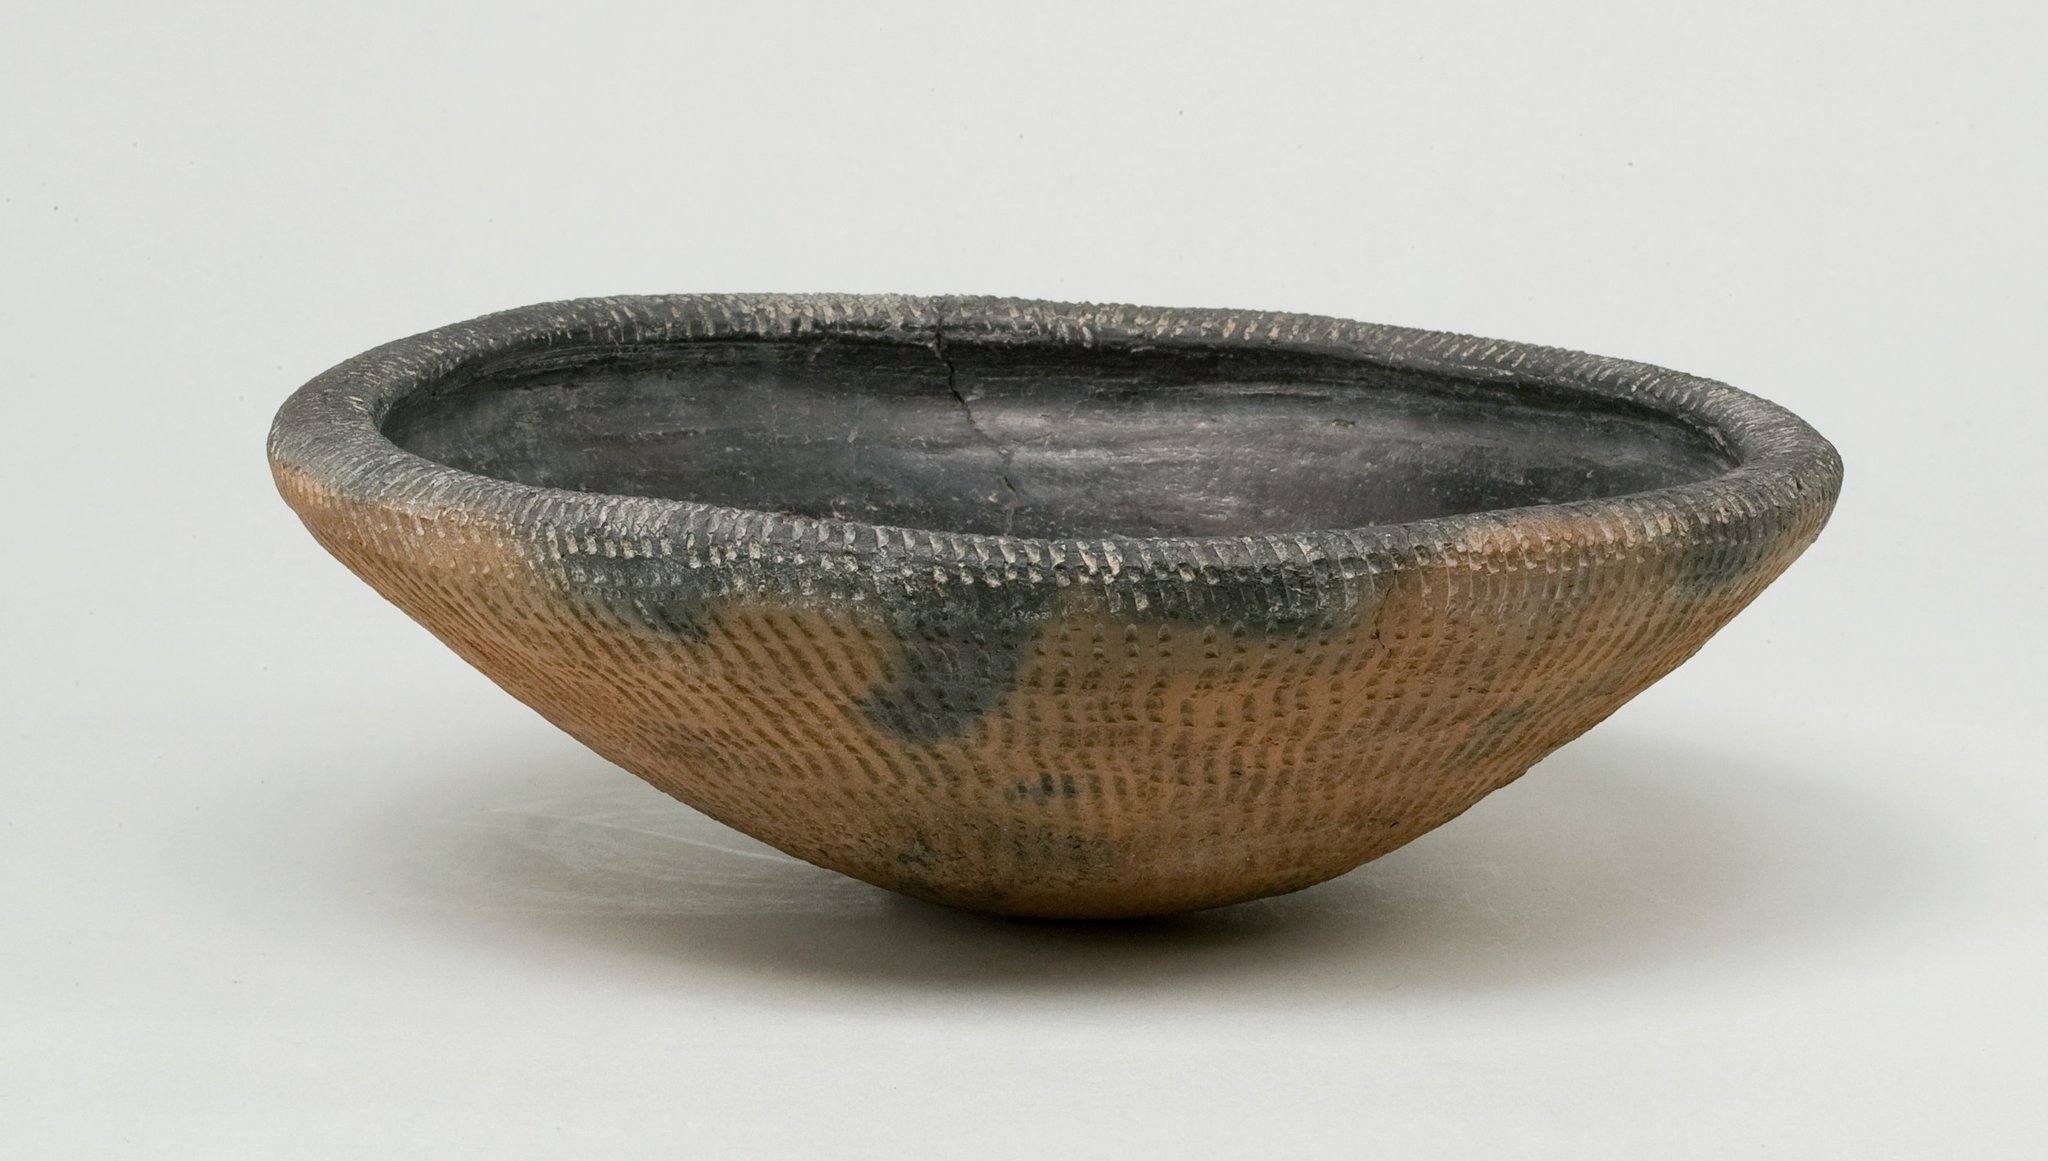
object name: bowl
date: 1550-1295 BCE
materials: pottery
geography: egypt